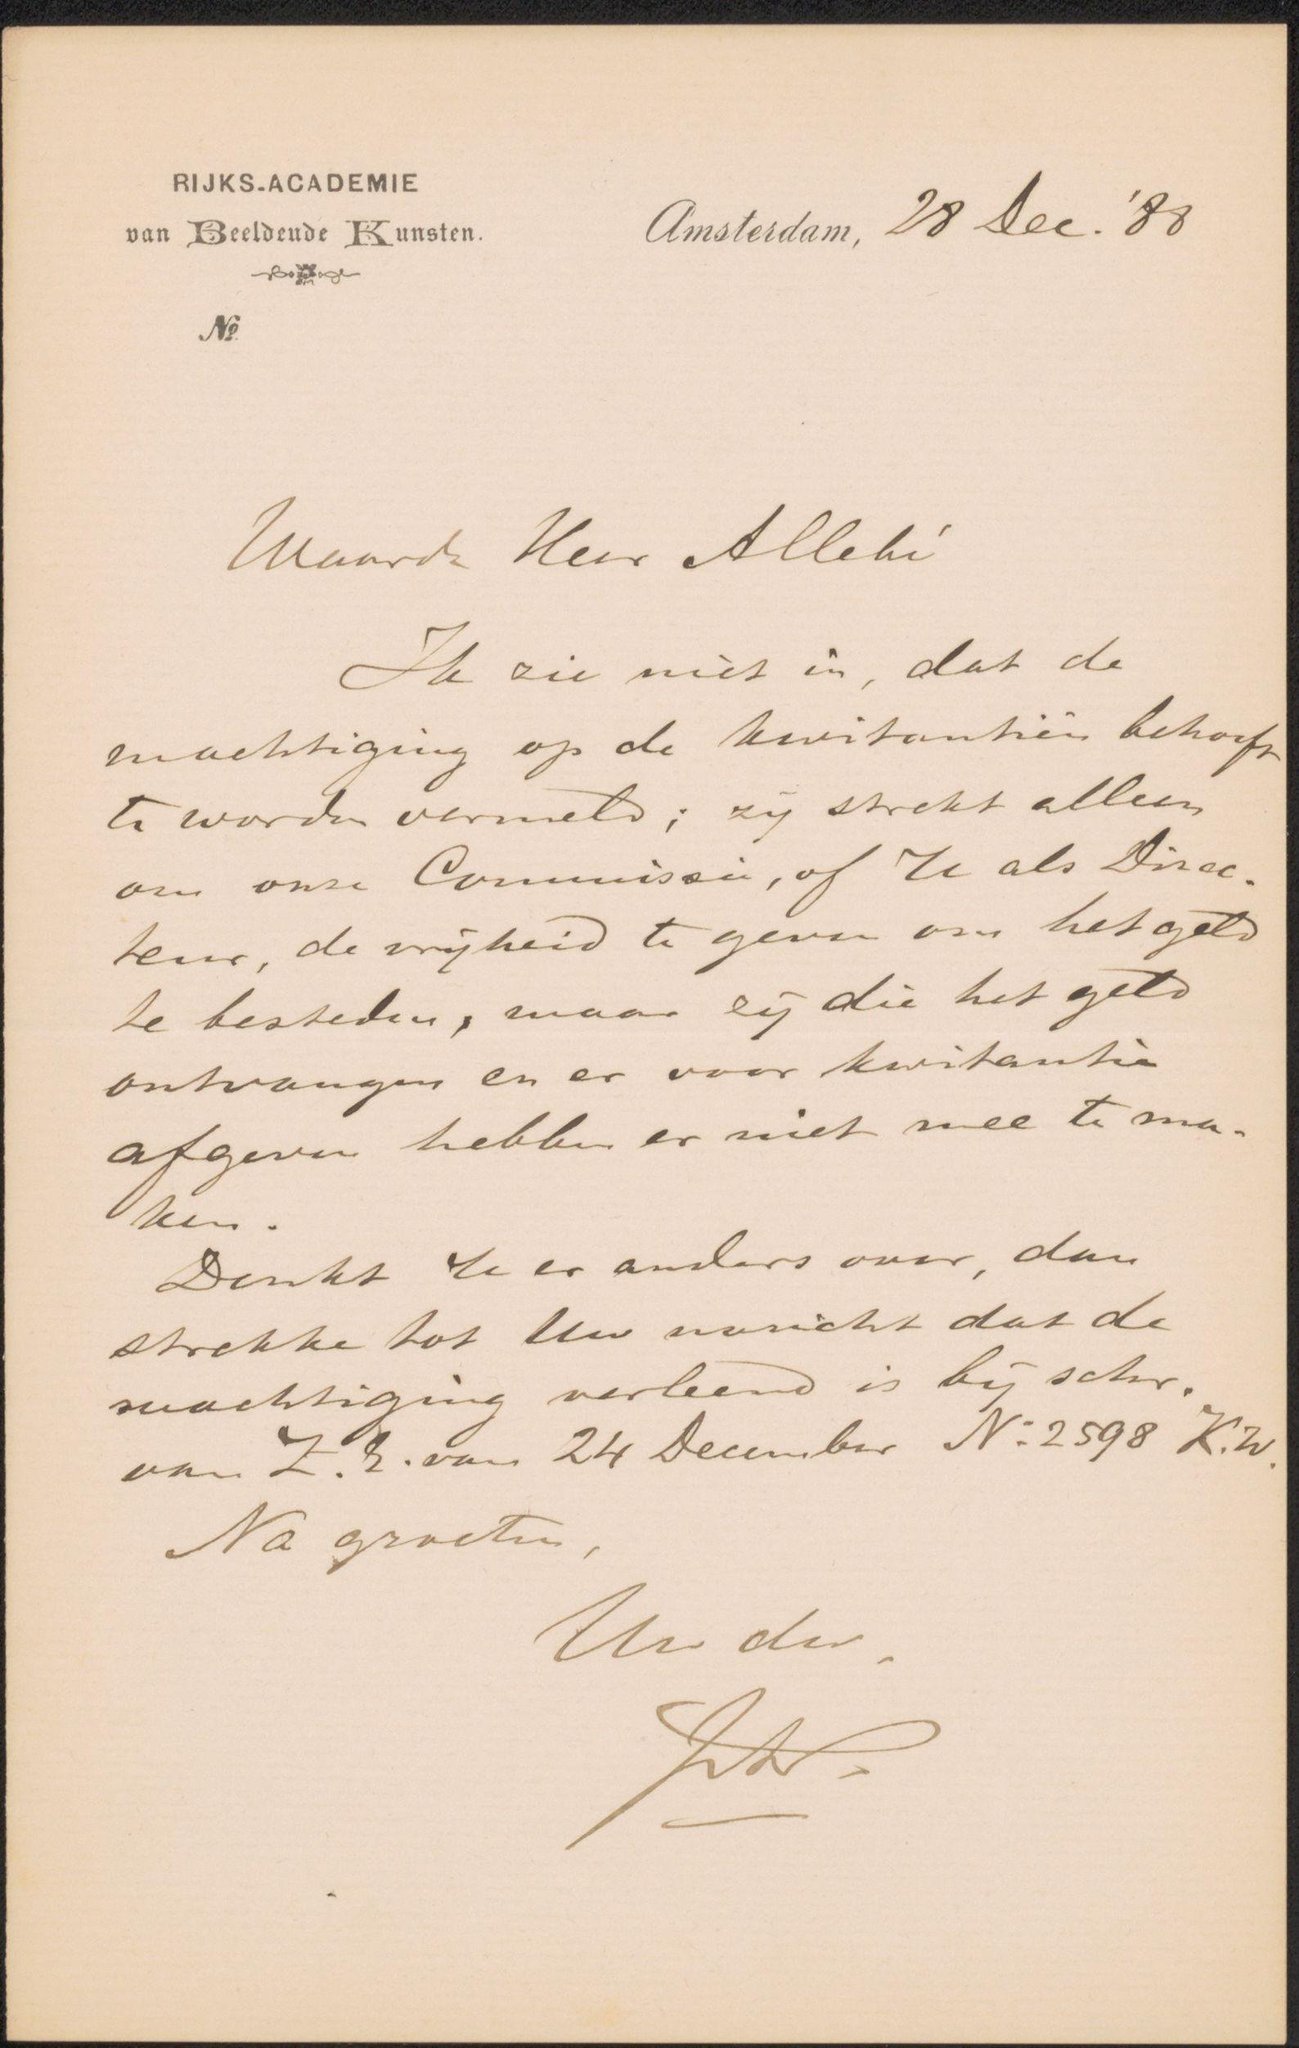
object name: letter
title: Brief aan August Allebé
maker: jérôme alexander sillem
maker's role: politician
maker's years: 1840-1912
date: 1888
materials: ink, paper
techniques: pen, printing, writing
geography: amsterdam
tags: print maker, draughtsman, august allebé, money